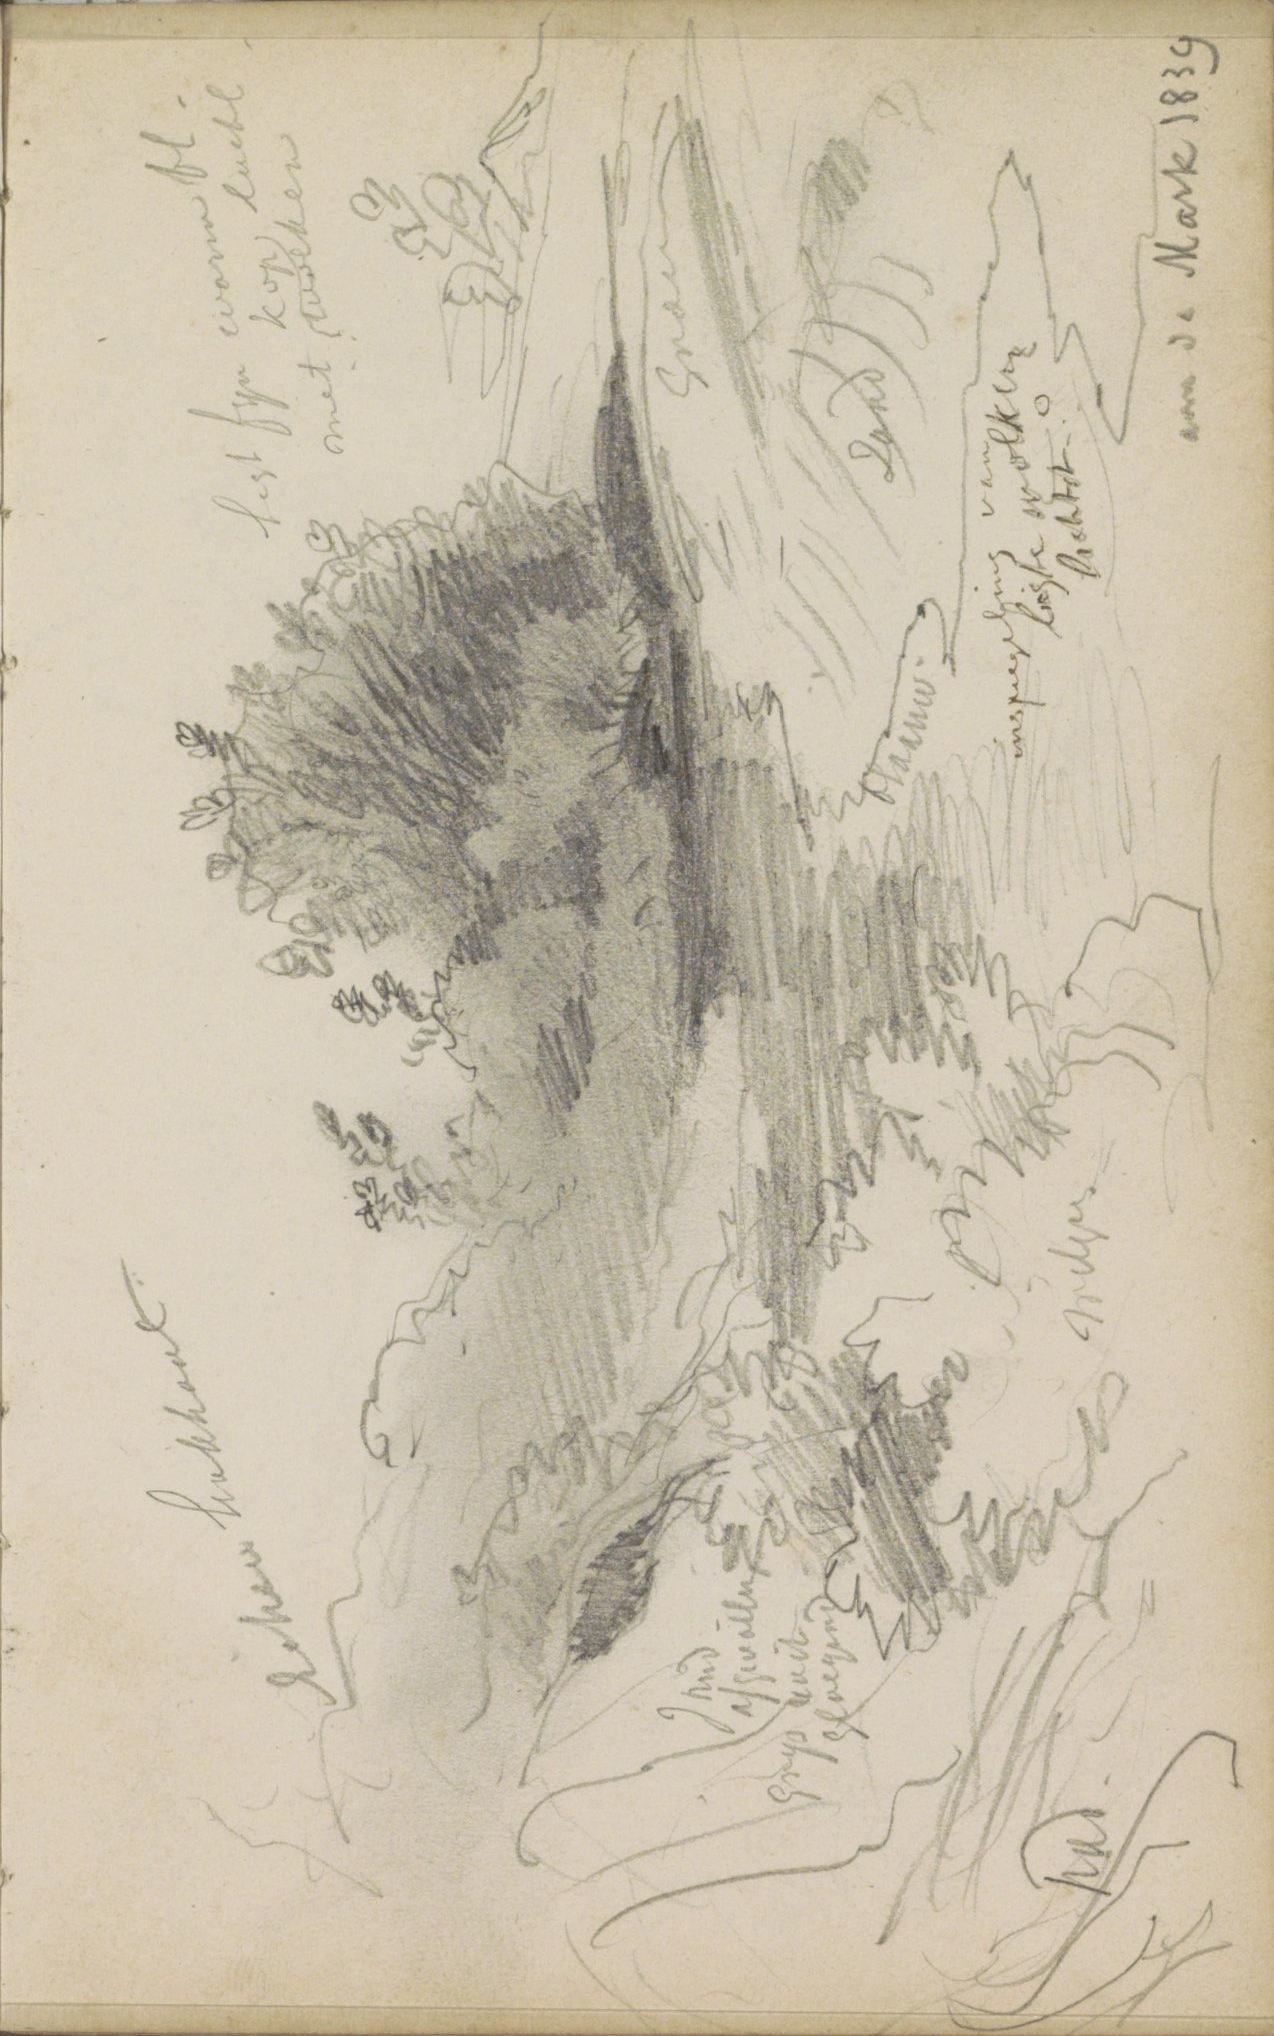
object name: sketchbook leaf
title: De rivier de Mark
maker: johannes tavenraat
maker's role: draughtsman, painter, print maker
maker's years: 1809-1881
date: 1839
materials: paper, pencil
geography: north brabant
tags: river, shrubs, landscapes with waters, waterscapes, seascapes (in the temperate zone)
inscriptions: date and inscription: ‘aan de Mark 1839’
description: Blad 36 recto uit een schetsboek met 73 bladen.